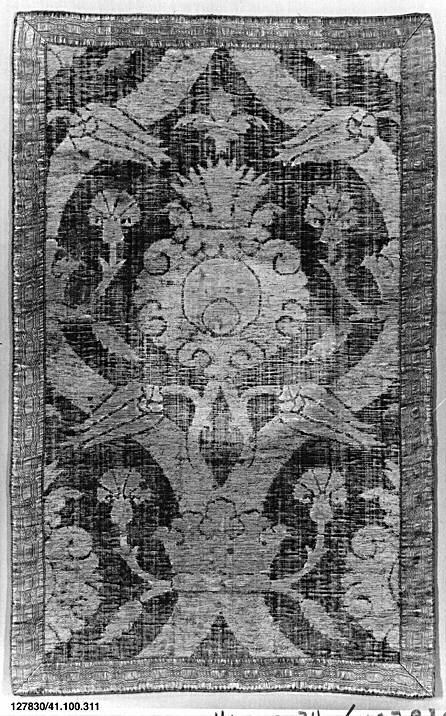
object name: panel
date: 1501-1600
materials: metal thread, silk, silver, silver gilt, thread, velvet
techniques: brocade, cutting, voiding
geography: turkey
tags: flowers